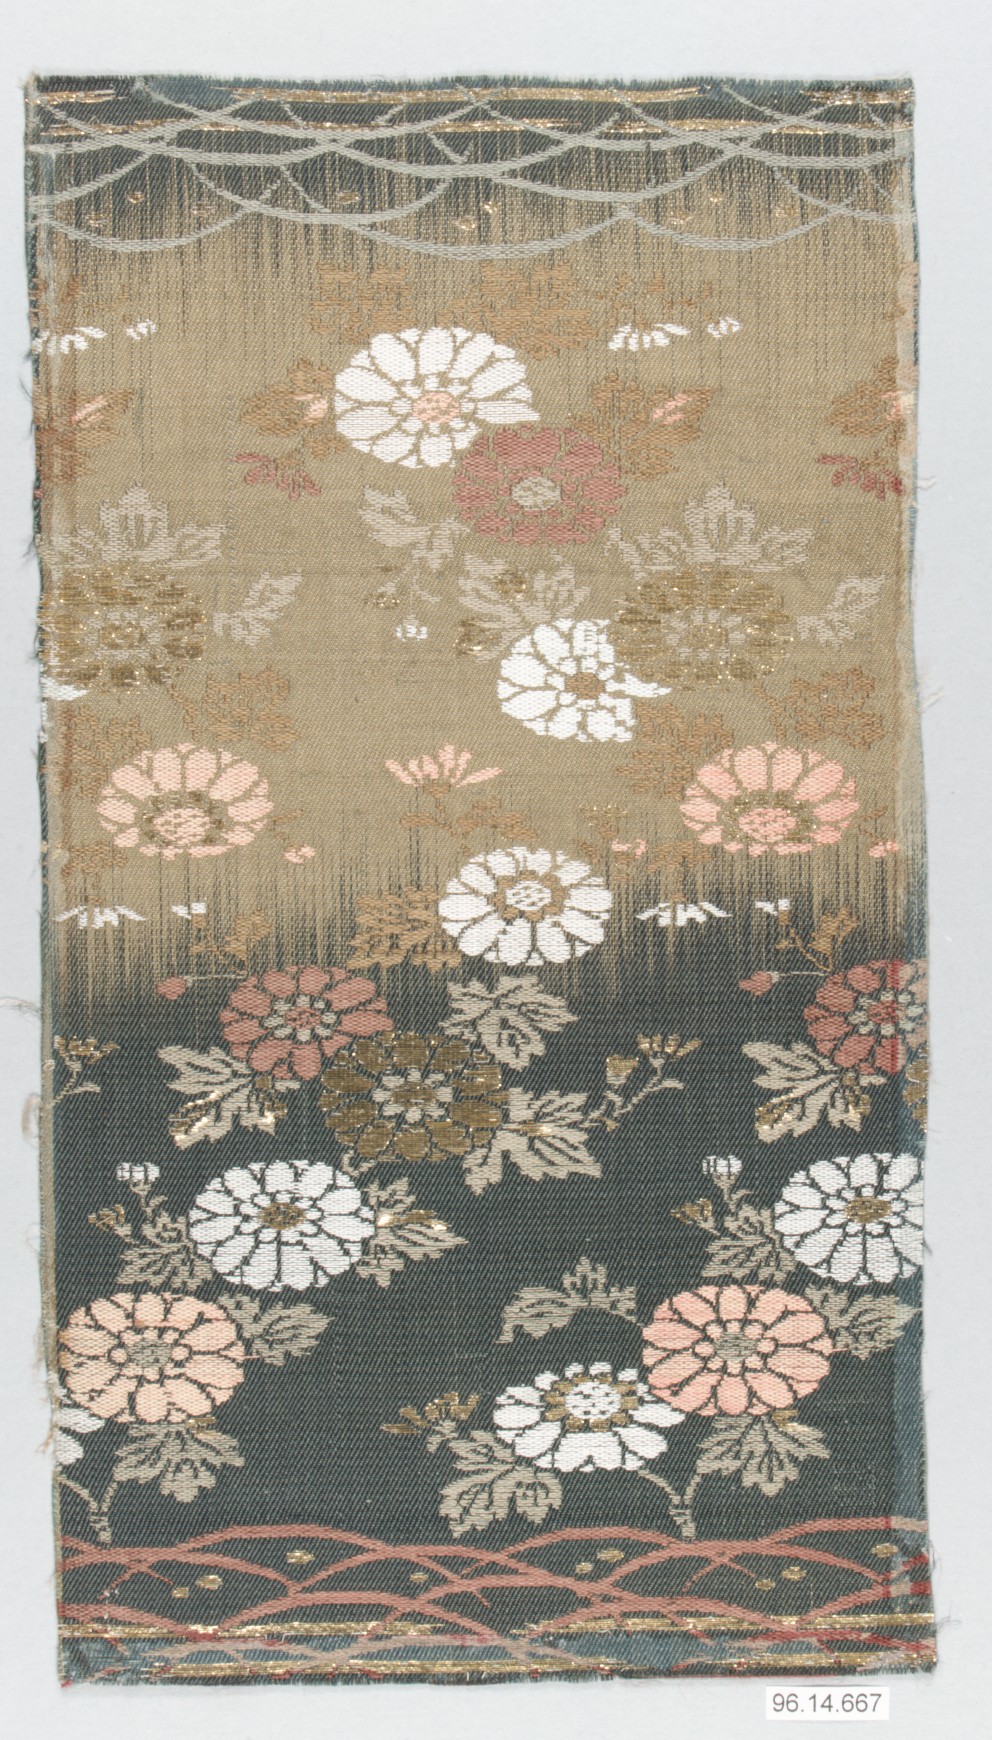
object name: piece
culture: japanese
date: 1701-1900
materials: metal thread, silk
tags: flowers